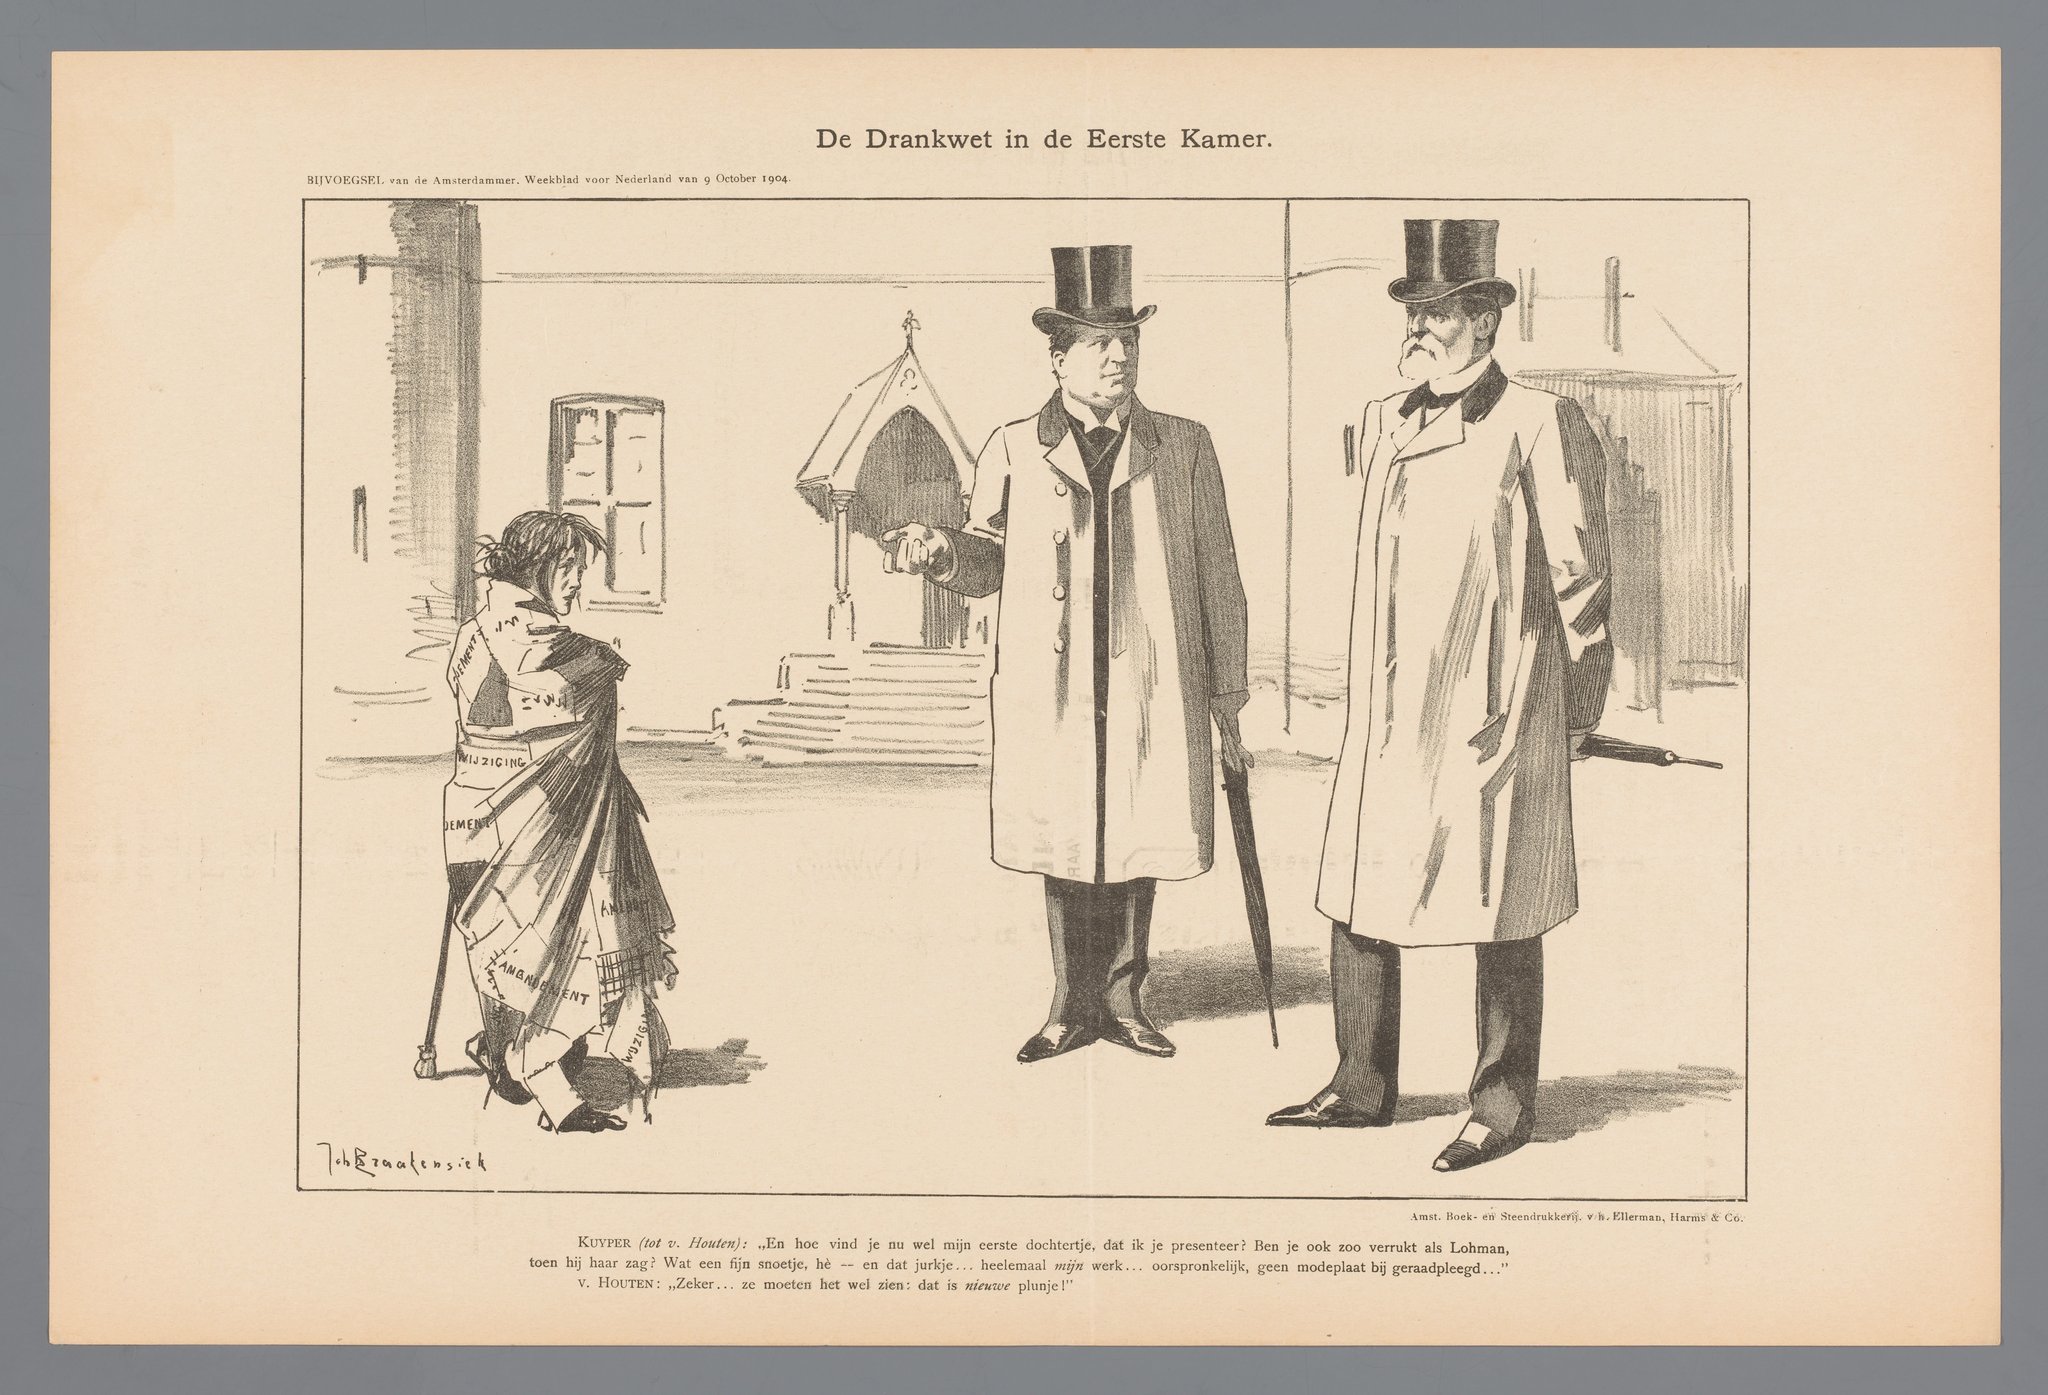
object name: cartoon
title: De Drankwet in de Eerste Kamer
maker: johan braakensiek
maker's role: draughtsman, print maker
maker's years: 1858-1940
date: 1904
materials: paper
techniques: lithograph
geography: amsterdam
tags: abraham kuyper, the hague, politician, samuel van houten, alcoholism, historical persons, political caricatures and satires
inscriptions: date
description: Prent uit het bijvoegsel van: De Amsterdammer. Weekblad voor Nederland, 9 oktober 1904.